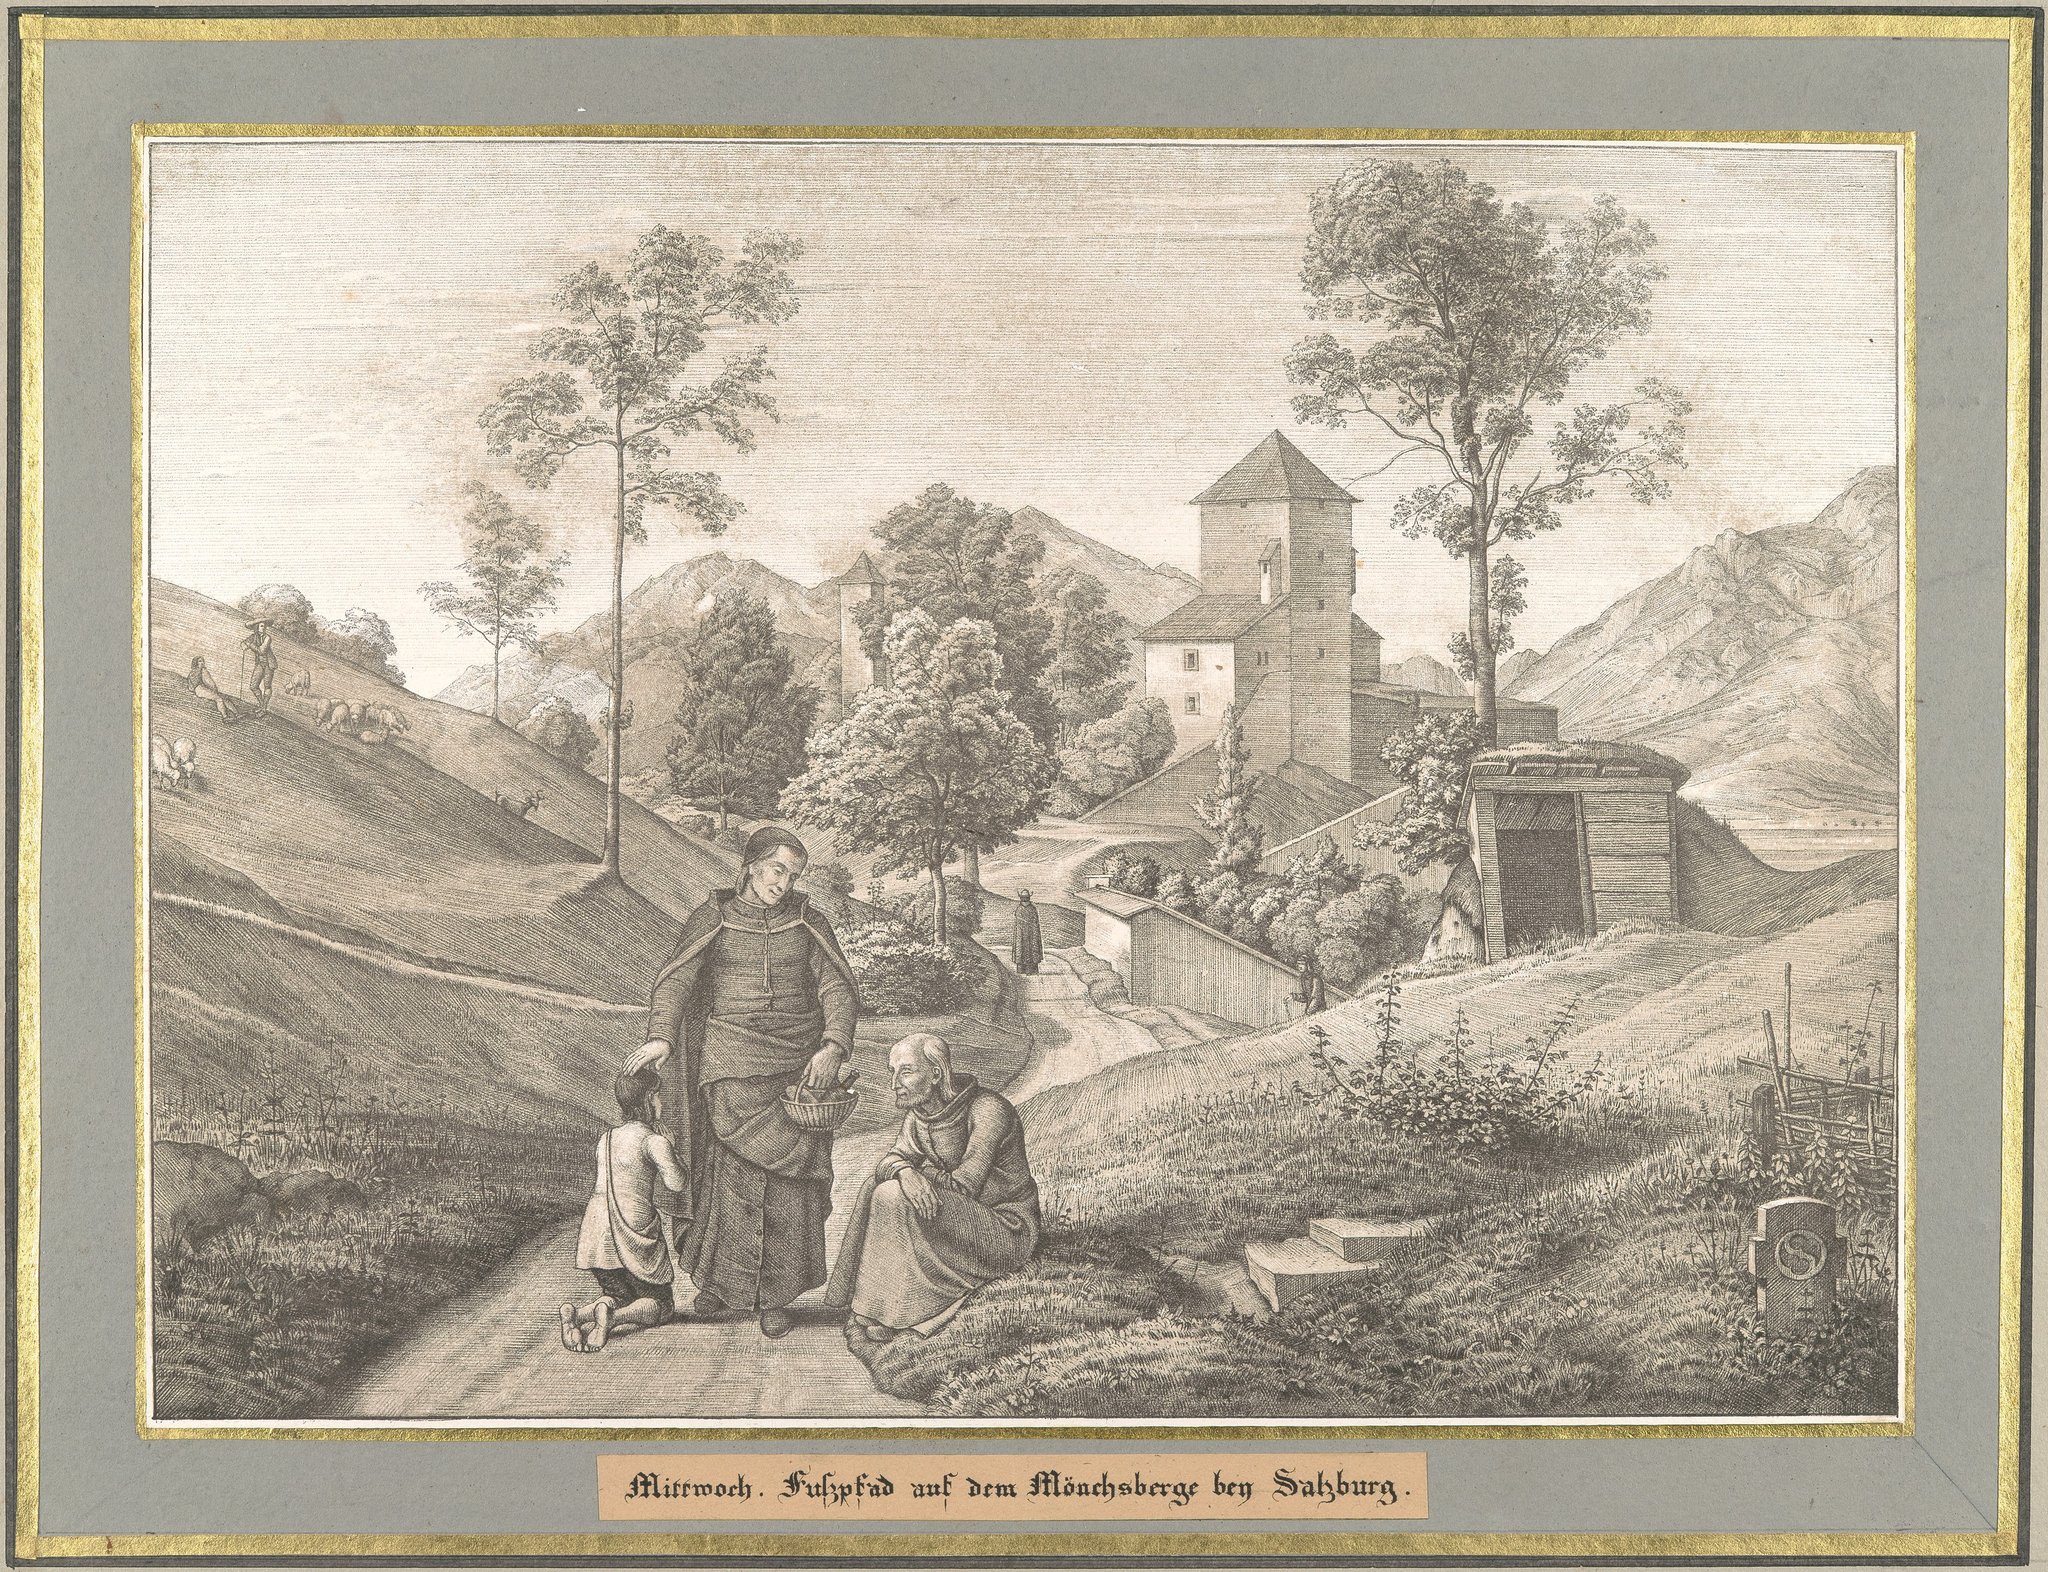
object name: print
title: Mittwoch from Sieben Gegenden aus Salzburg und Berchtesgaden Geordnet nach den sieben Tagen der Woche, verbunden durch zwey allegorische Blätter (Seven Places in Salzburg and Berchtesgaden, Arranged According to the Seven Days of the Week)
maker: (johann heinrich) ferdinand olivier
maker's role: artist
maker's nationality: german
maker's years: 1785-1841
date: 1800-1841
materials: board, gilt, paper, ribbon, stone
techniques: lithograph, painting, printing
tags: buildings,men,hills,trees